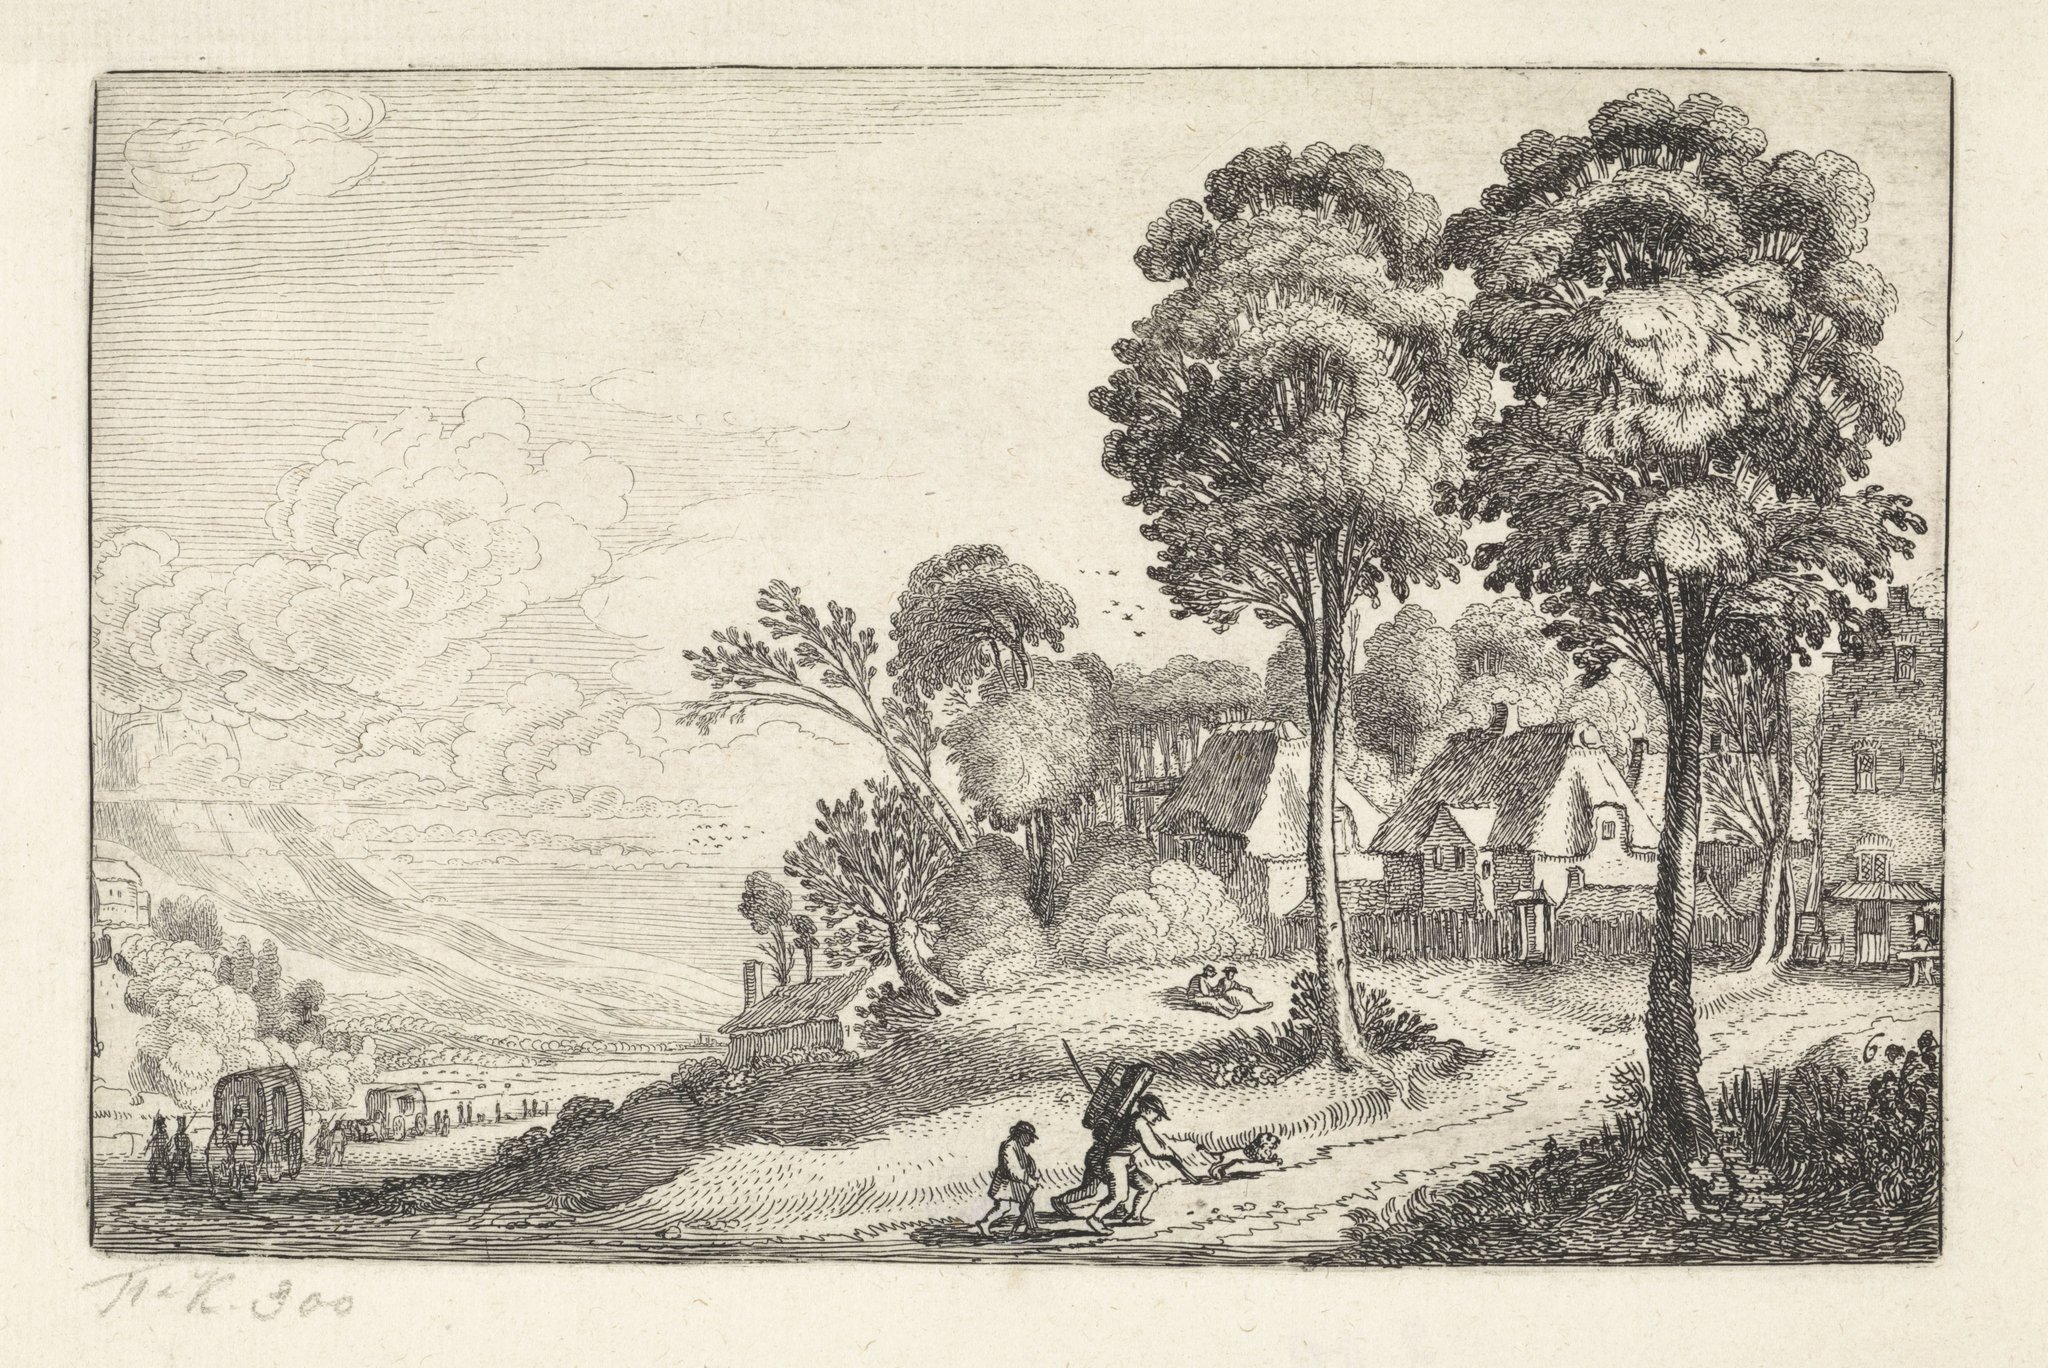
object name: print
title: Amenissimae aliquot requculae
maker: jan van de velde (ii)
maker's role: draughtsman, painter, print maker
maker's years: 1593-1641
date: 1616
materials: paper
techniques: etching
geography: northern netherlands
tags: village, 'en route', traveller under way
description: Reizigers op een pad bij een dorp in een bergachtig landschap. Zesde prent van deel twee van een serie van in totaal 52 prenten met landschappen, verdeeld over twee delen van elk 26 prenten.